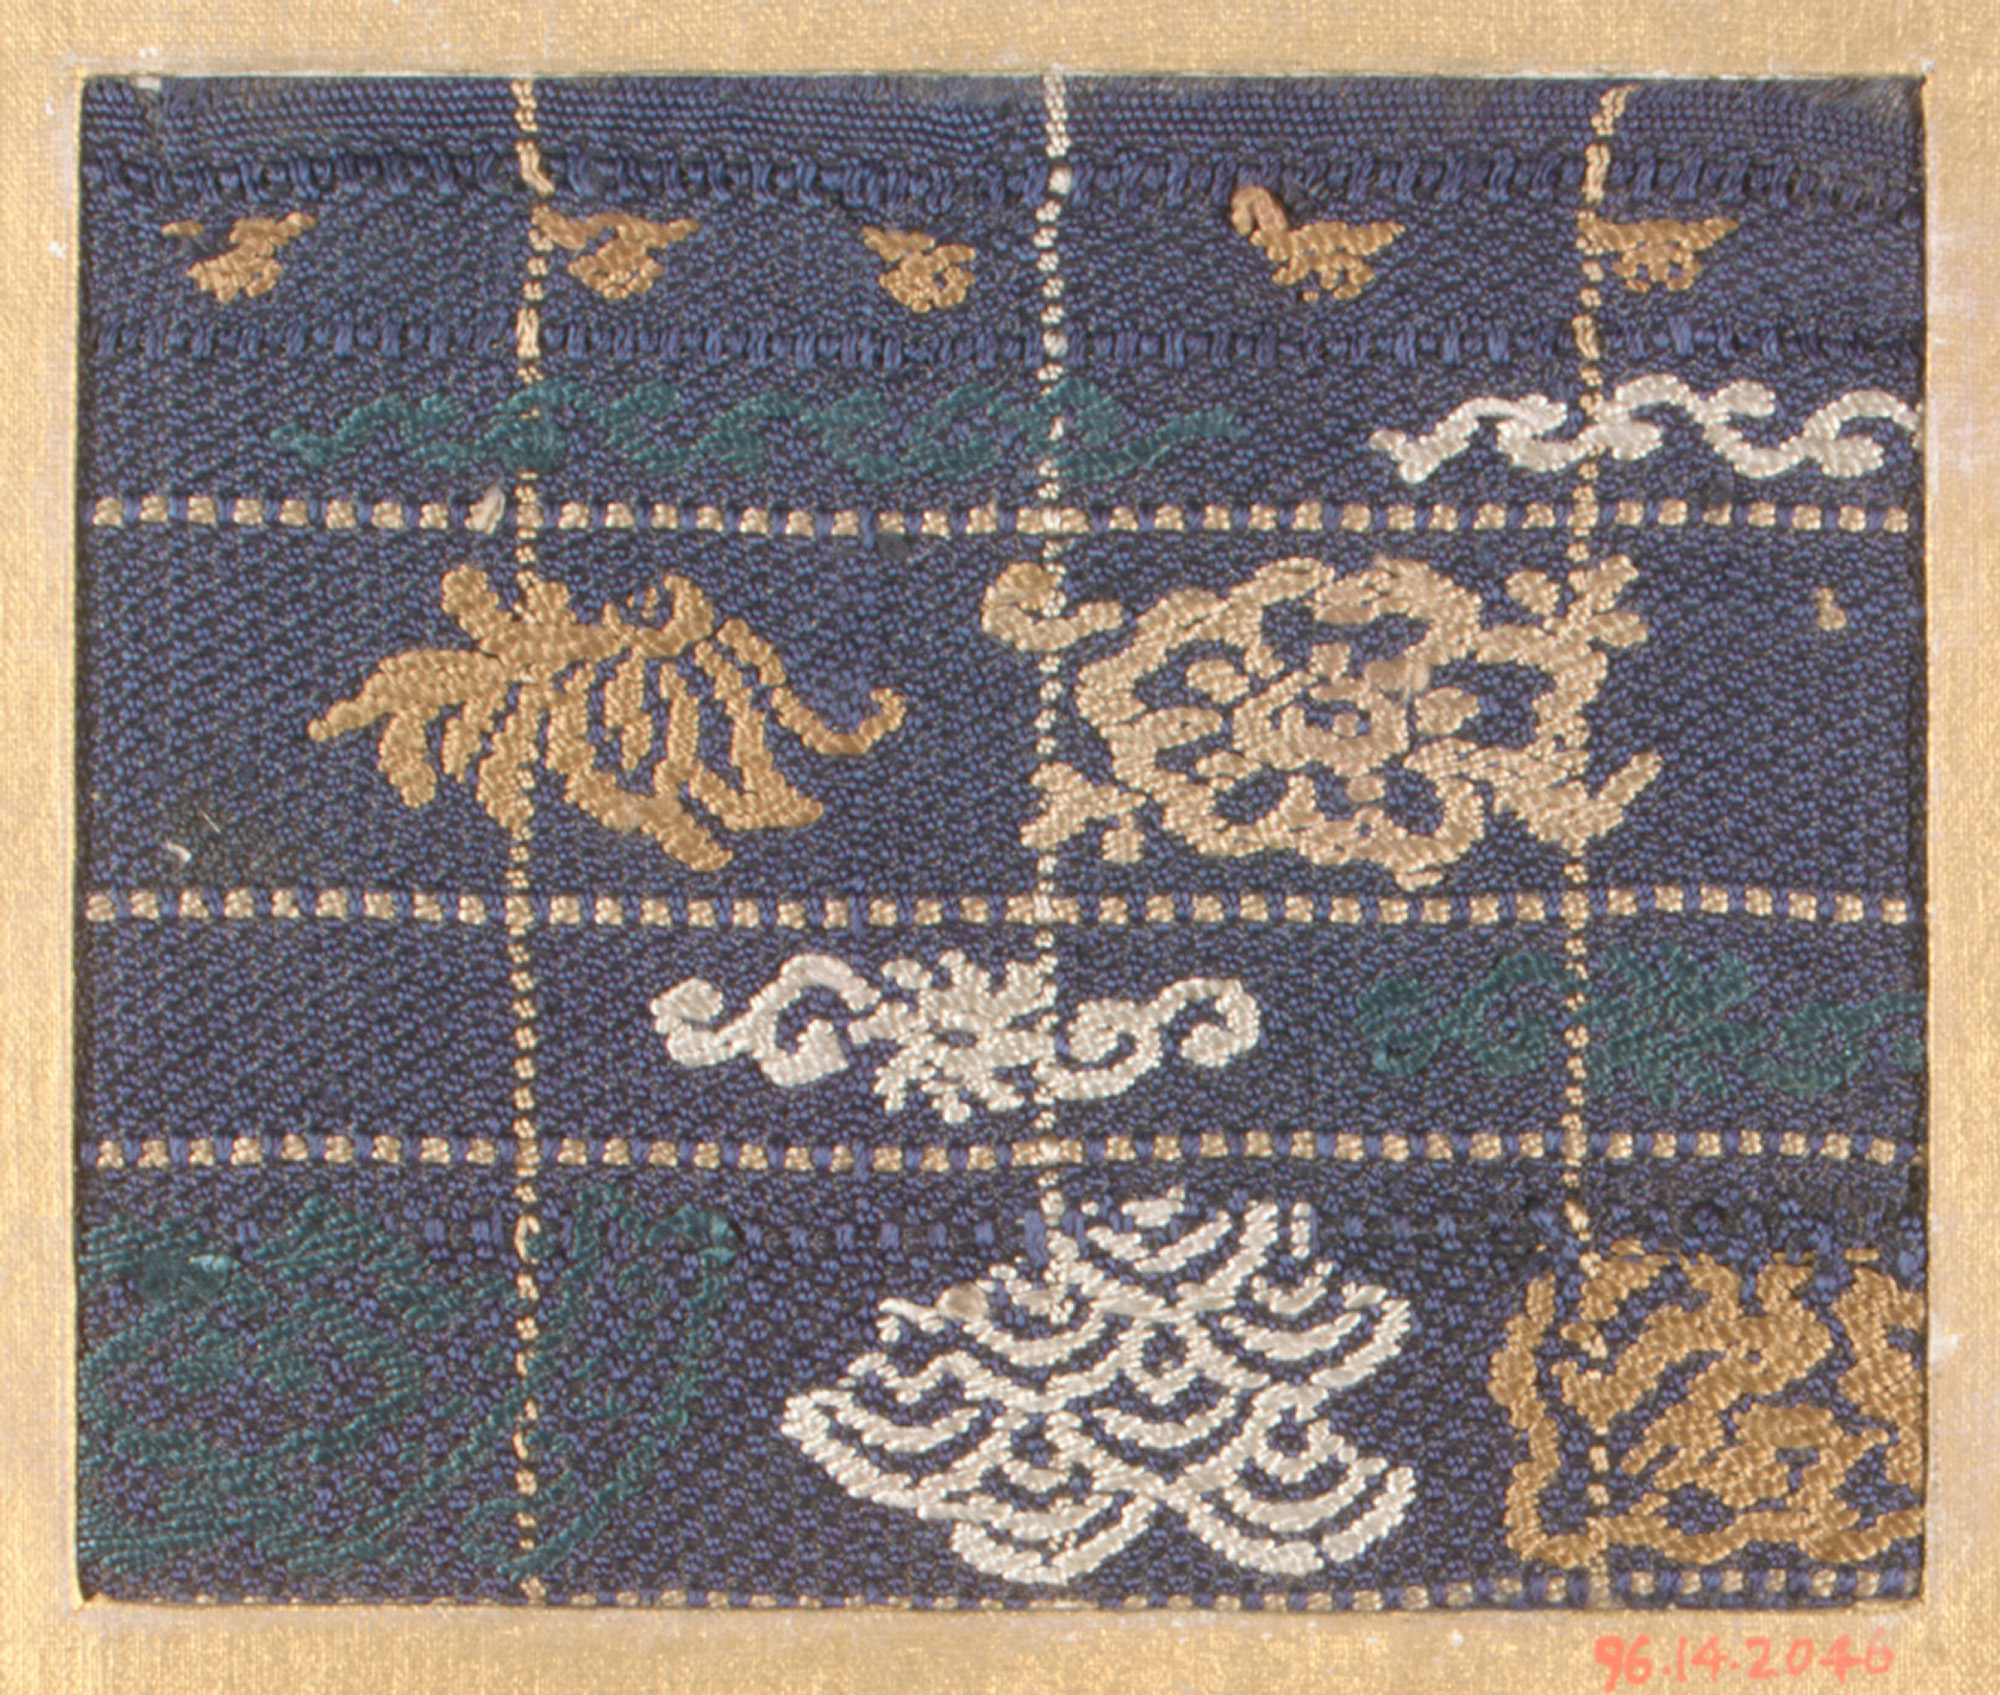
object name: piece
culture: japanese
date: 1701-1900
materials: silk